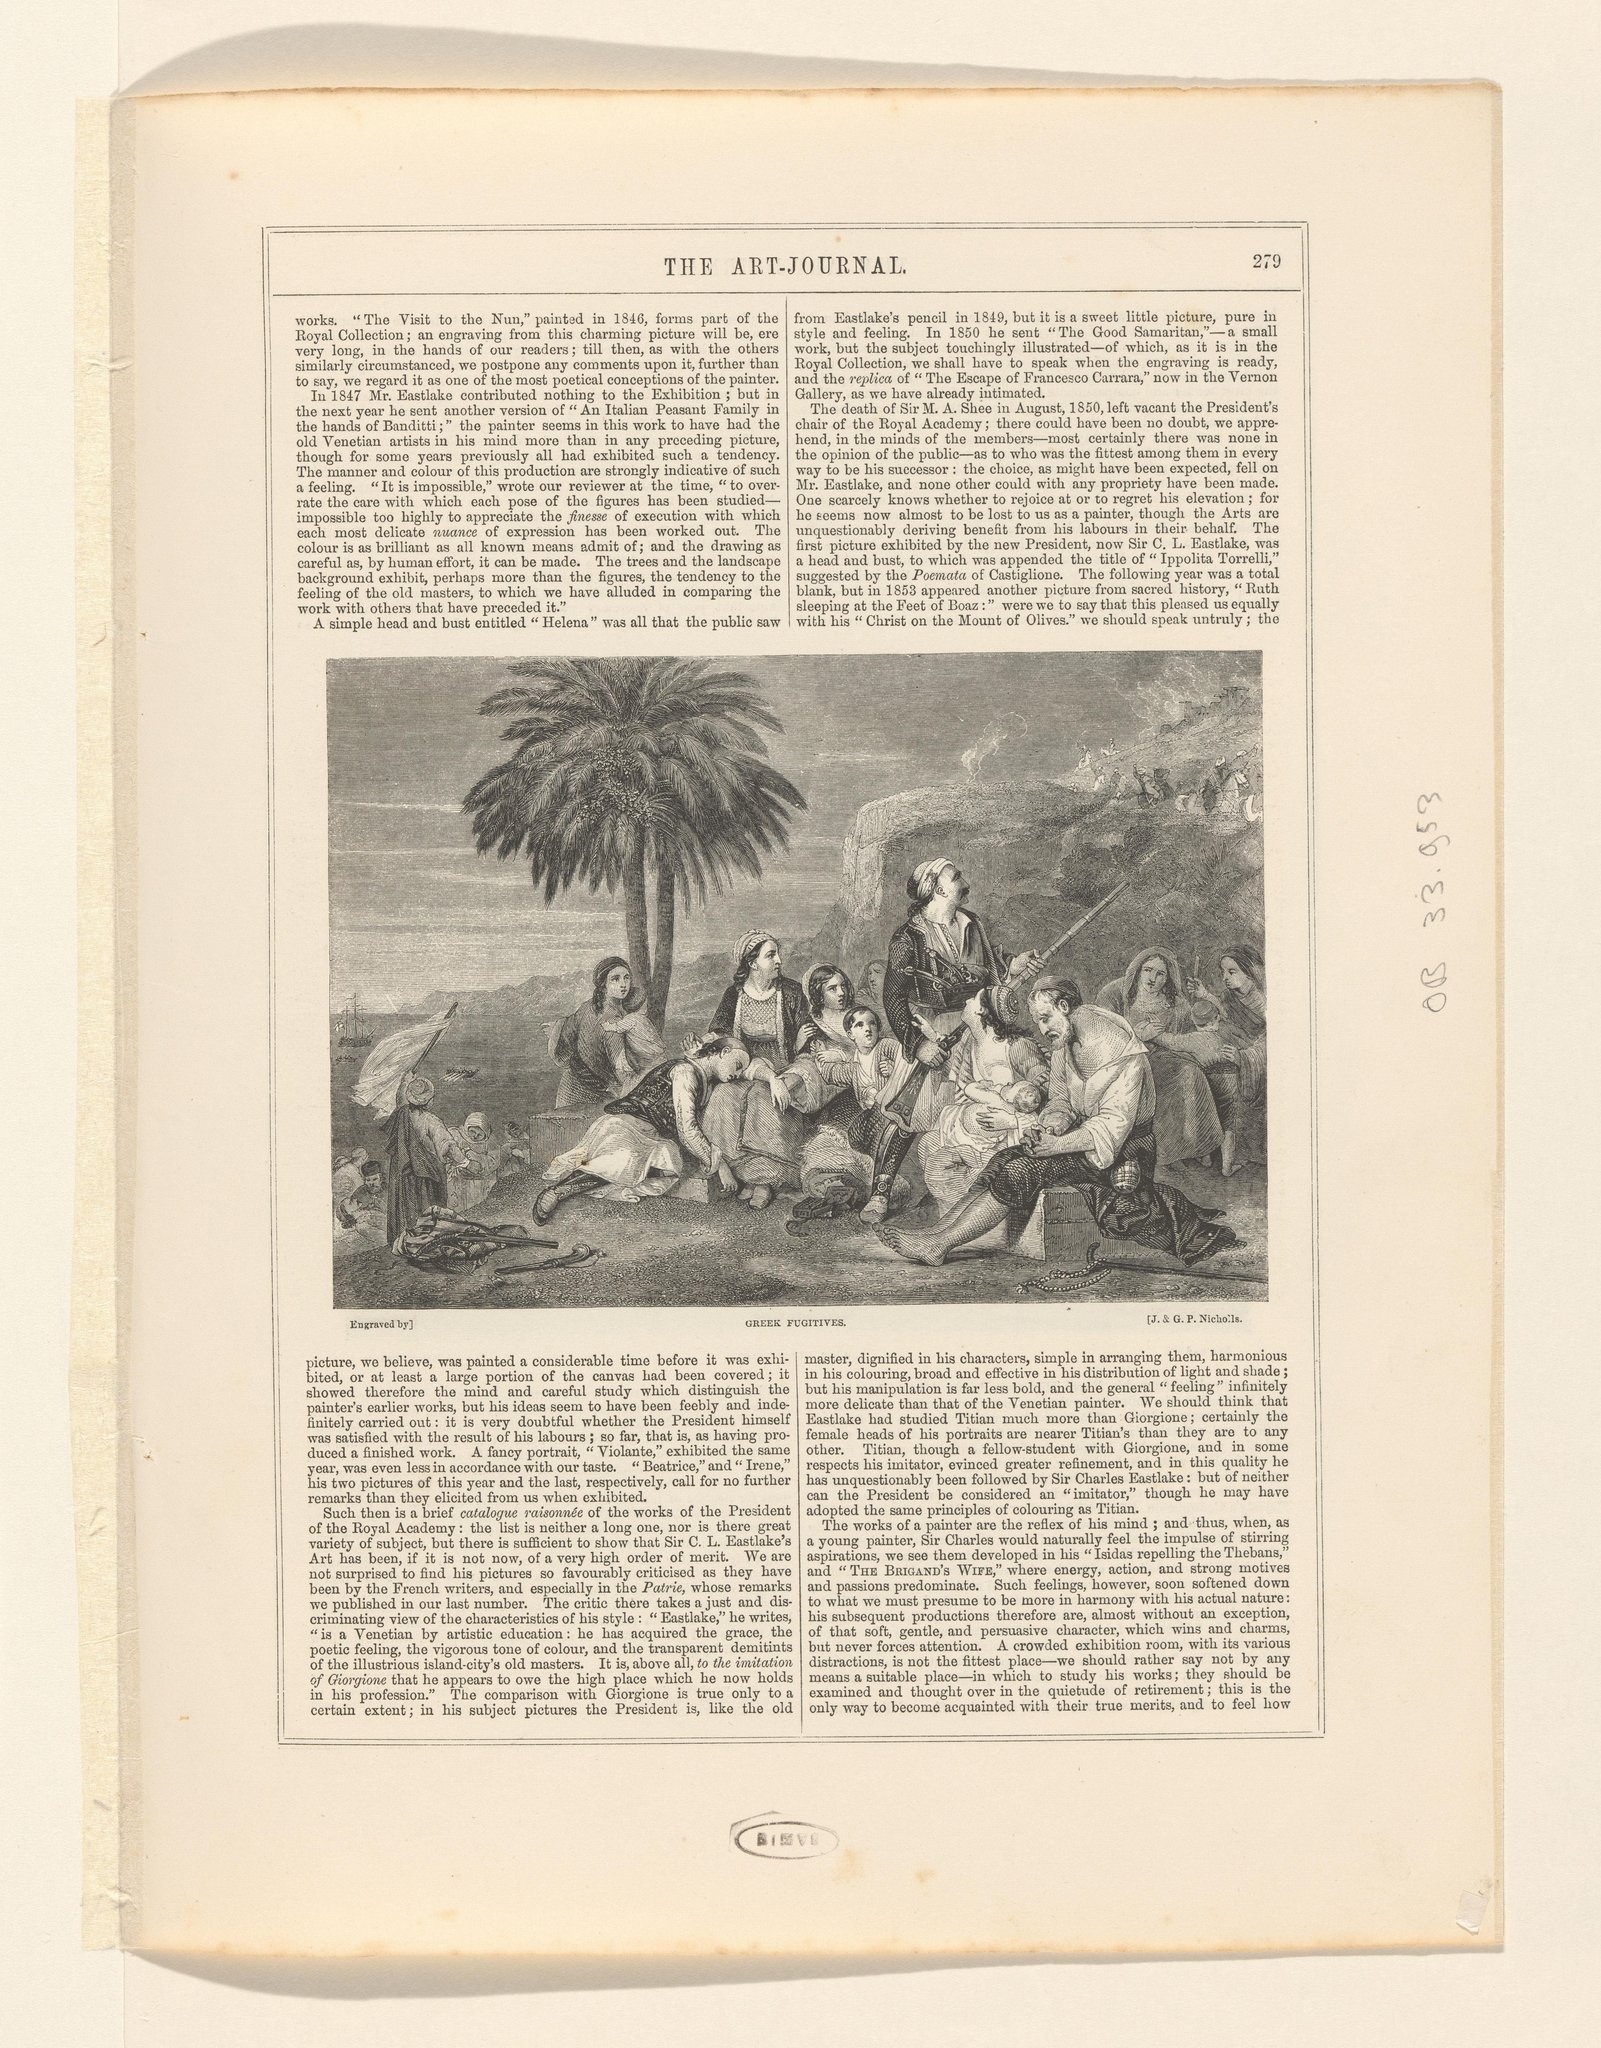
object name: print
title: Hagar and Ishmael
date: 1855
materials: paper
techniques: letterpress printing, engraving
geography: london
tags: giving drink, hagar and ishmael in the wilderness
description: Prent uit: The Art Journal (1855), 1855, p. 280.